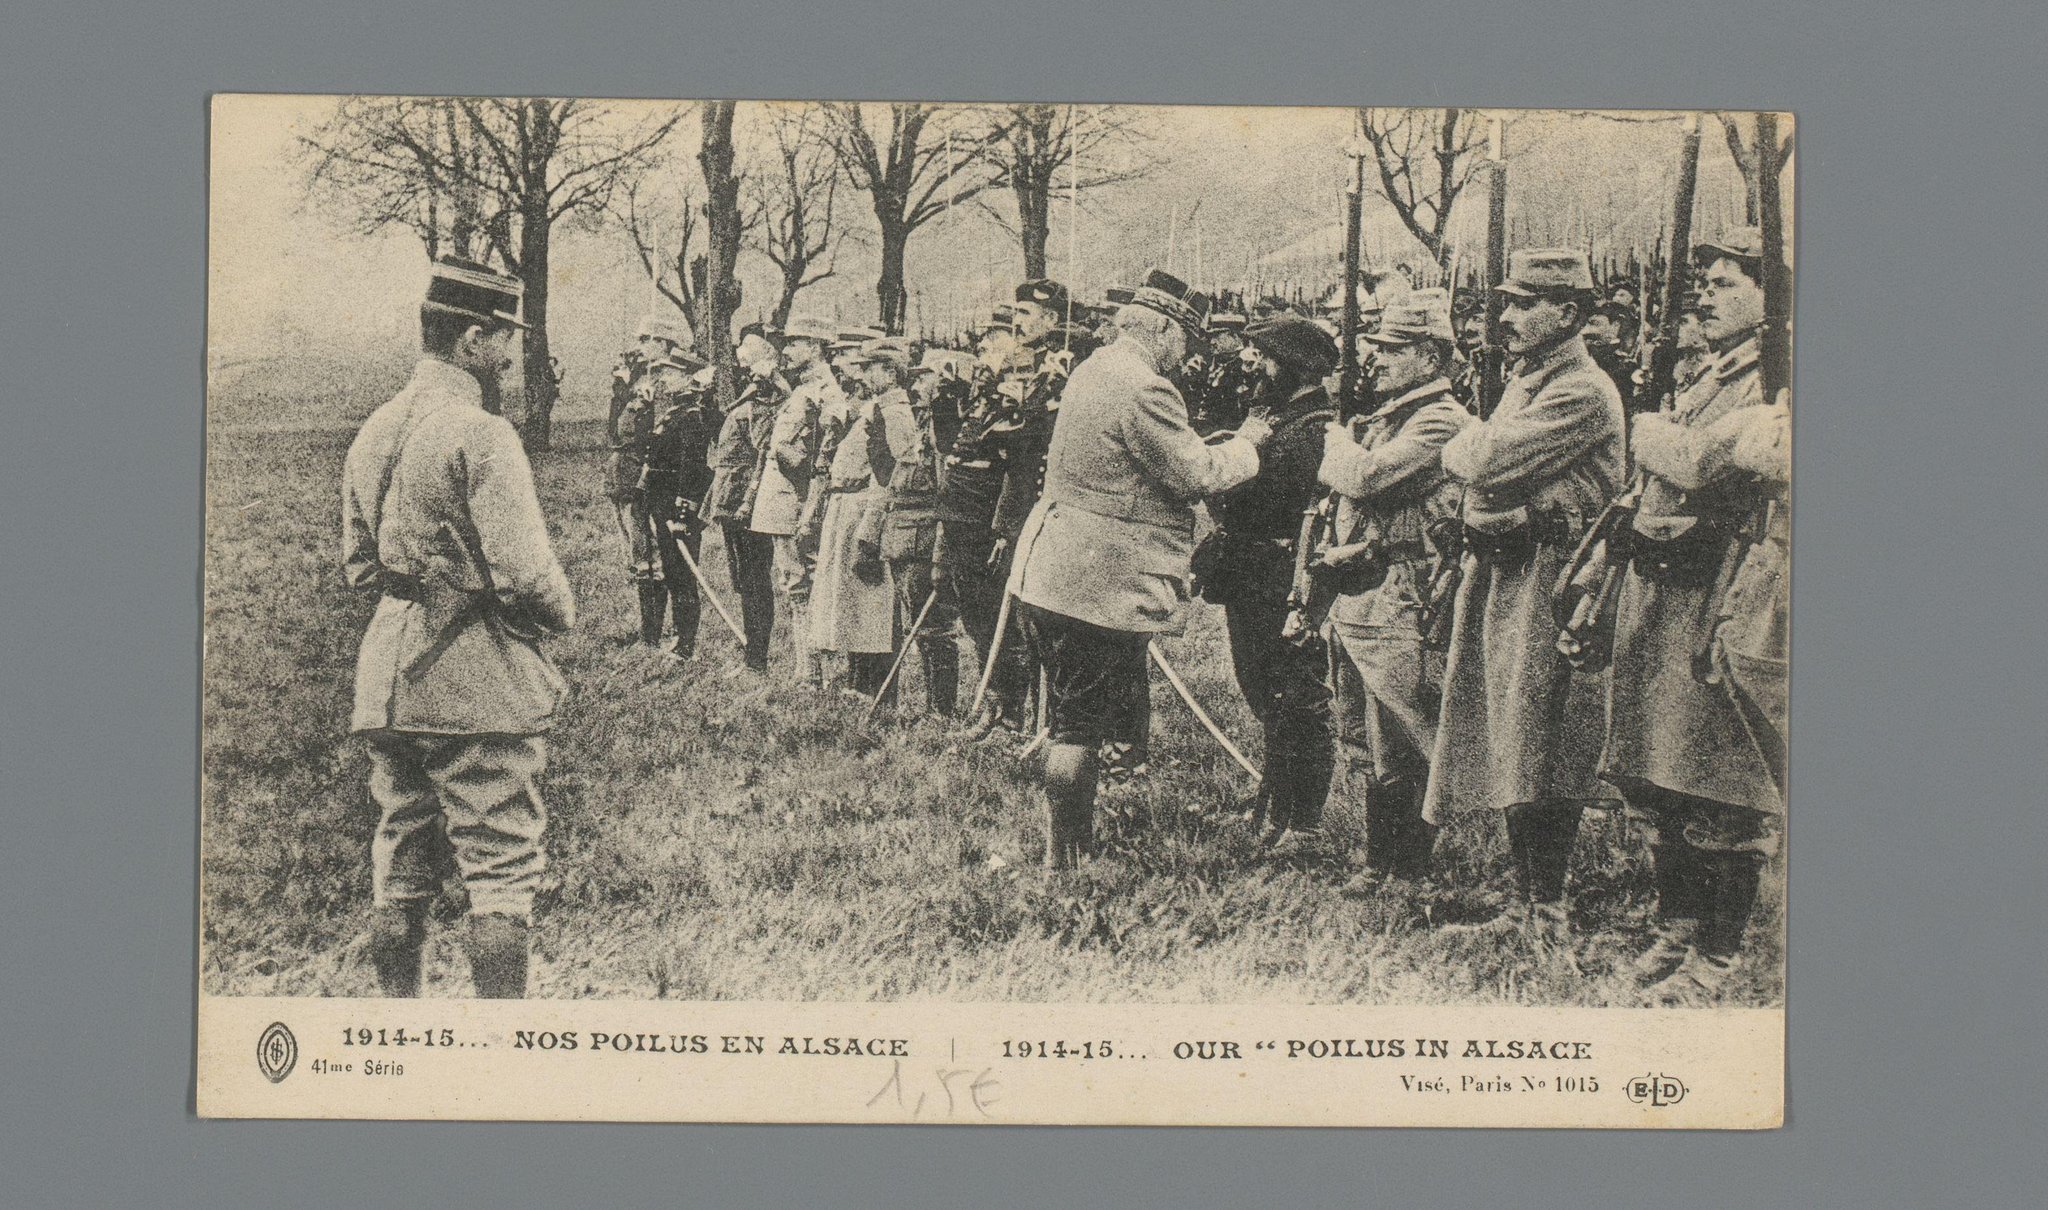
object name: ansichtkaart, prentbriefkaart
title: Franse soldaten in het gareel in de Elzas tijdens de Eerste Wereldoorlog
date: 1914-1915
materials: paper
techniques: rotogravure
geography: alsace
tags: the soldier; the soldier's life, alsace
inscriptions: inscription: ‘CARTE POSTALE/ Correspondance/ Adresse’, inscription: ‘41me Série/ Visé, Paris No 1015’